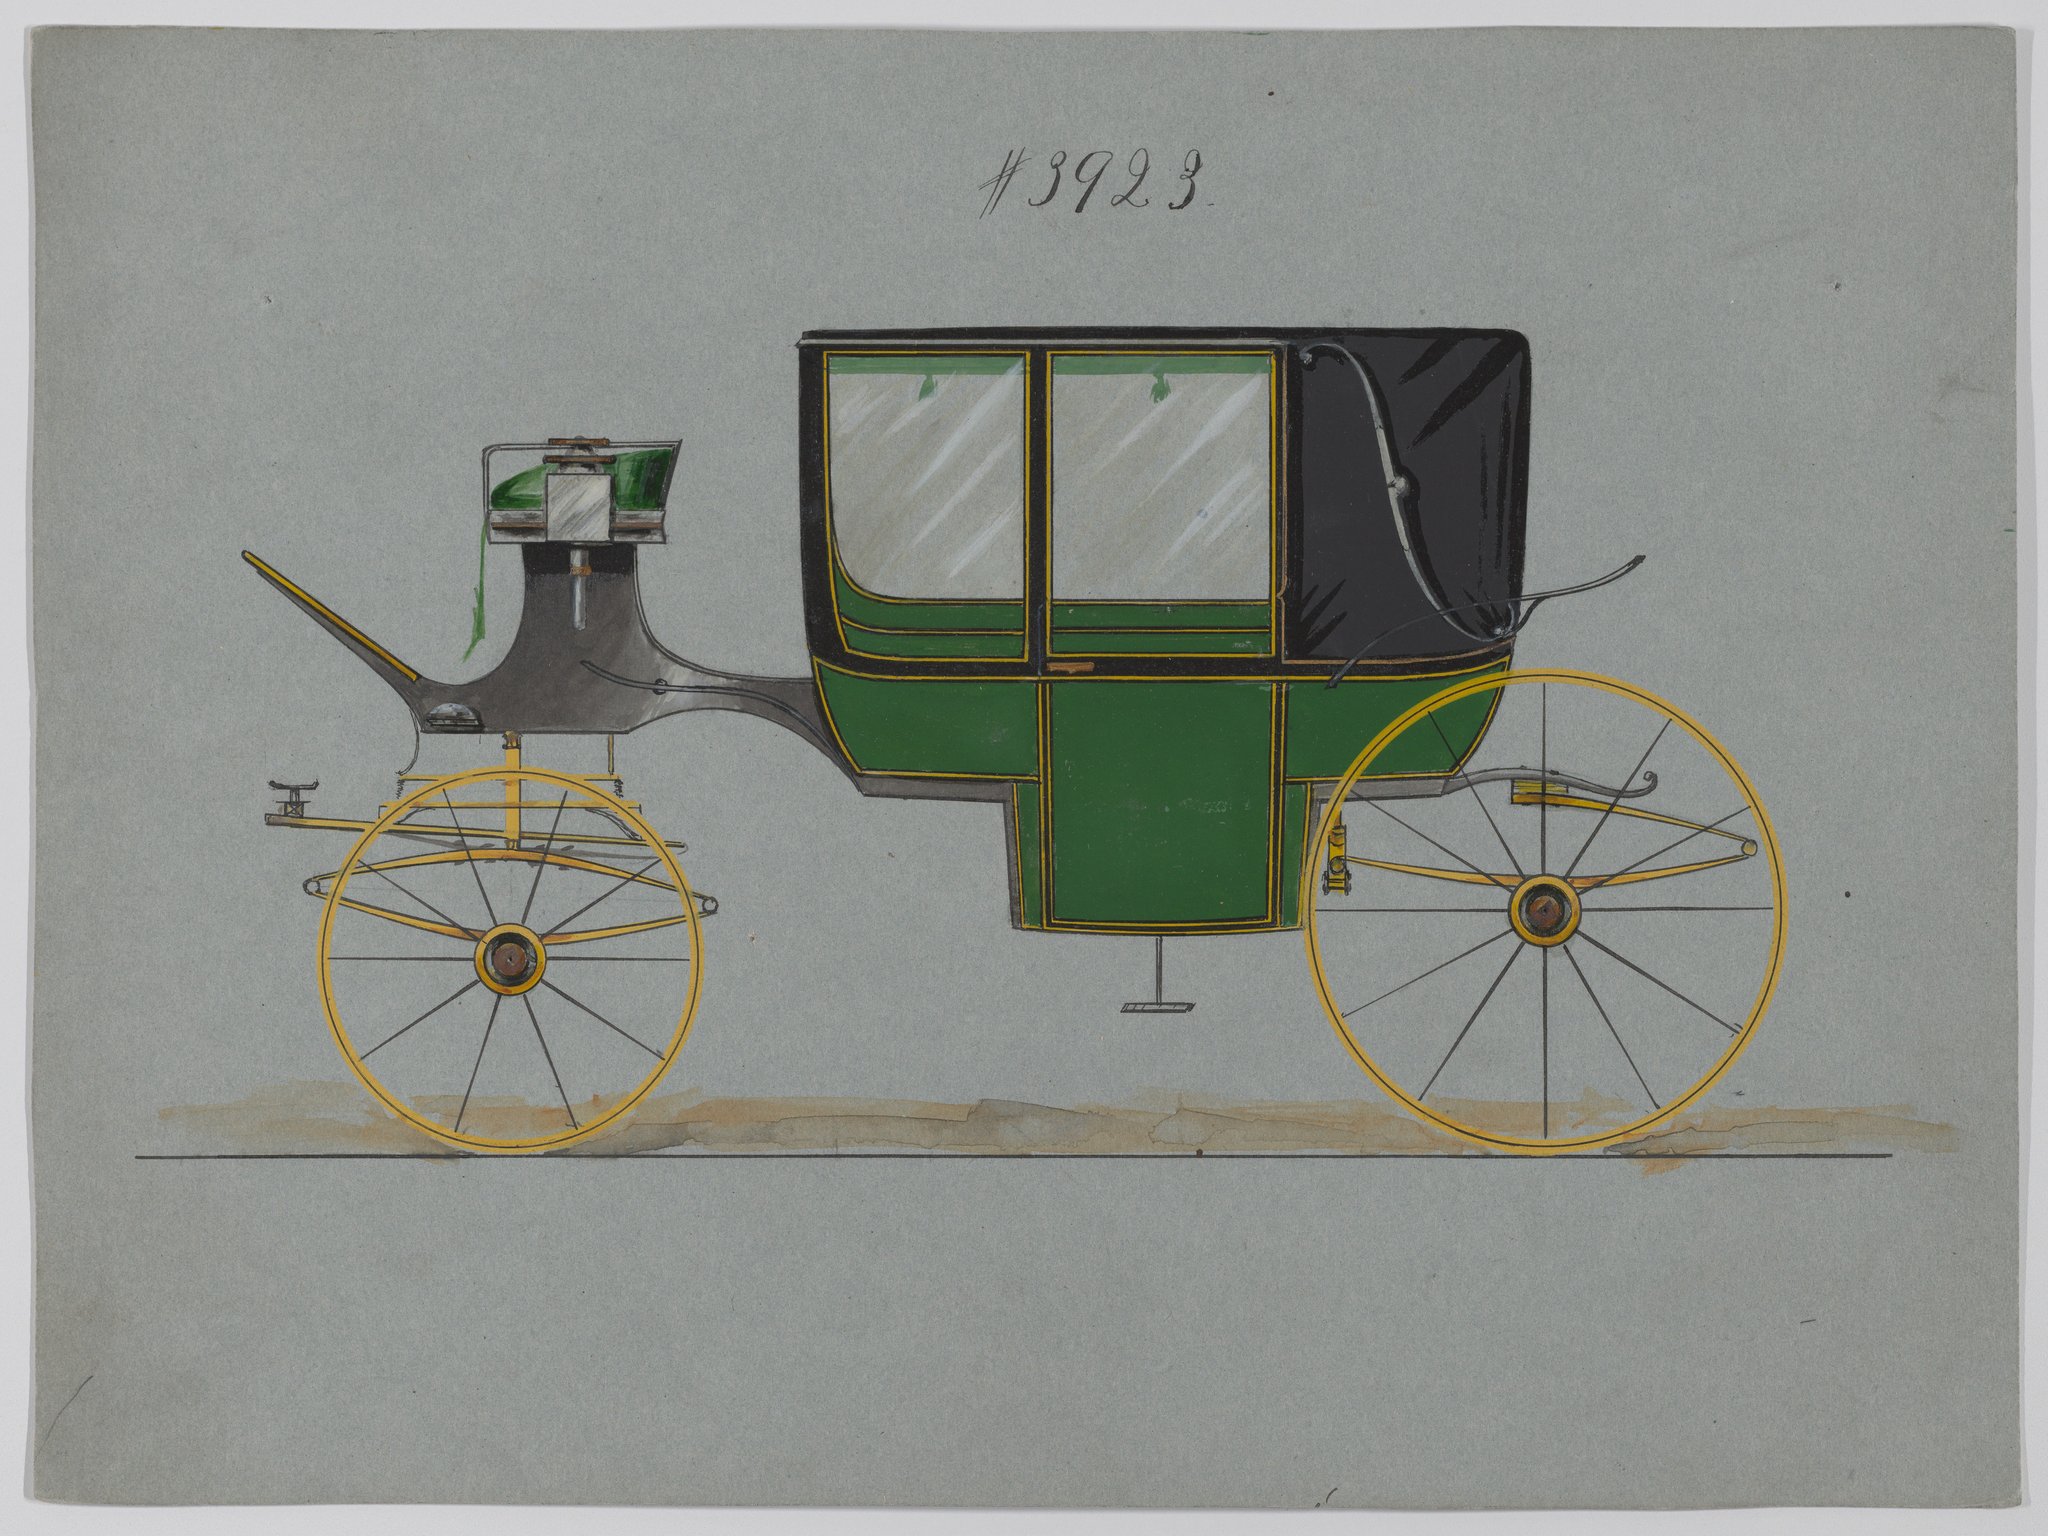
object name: drawing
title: Design for Landau, No. 3923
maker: brewster & co.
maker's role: manufacturer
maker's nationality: american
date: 1884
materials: gouache, gum arabic, ink, watercolor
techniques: pen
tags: carriages